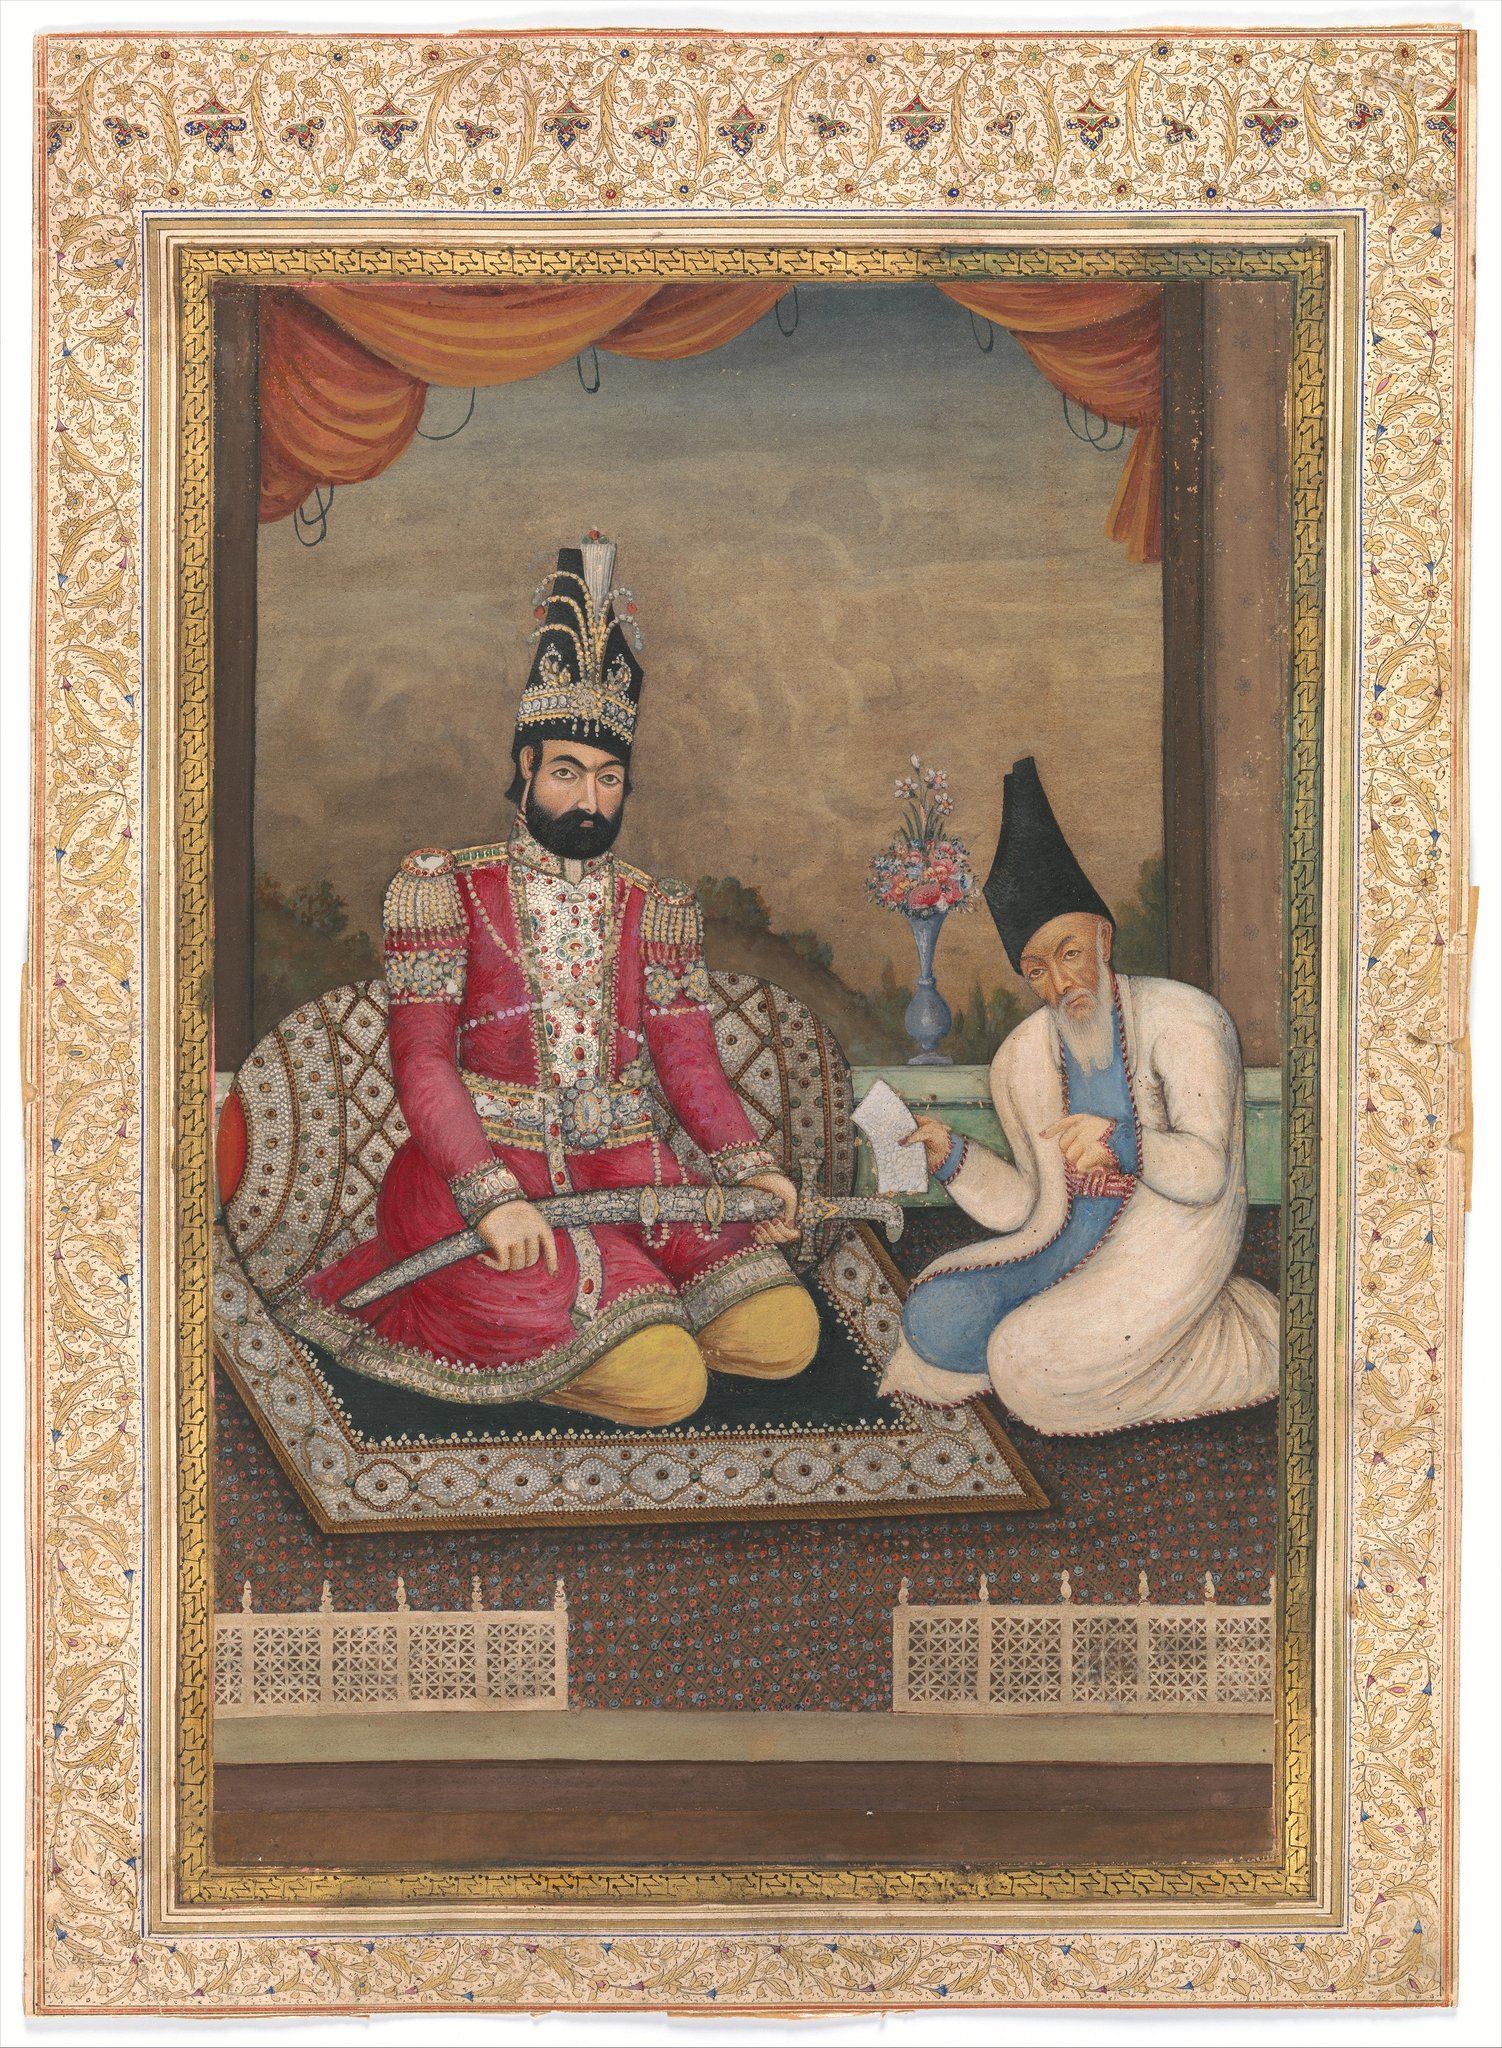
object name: illustrated single work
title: Portrait of Muhammad Shah Qajar and his Vizier Haj Mirza Aghasi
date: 1826-1850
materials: gold, ink, paper, watercolor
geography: iran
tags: military clothing,swords,kings,men,portraits